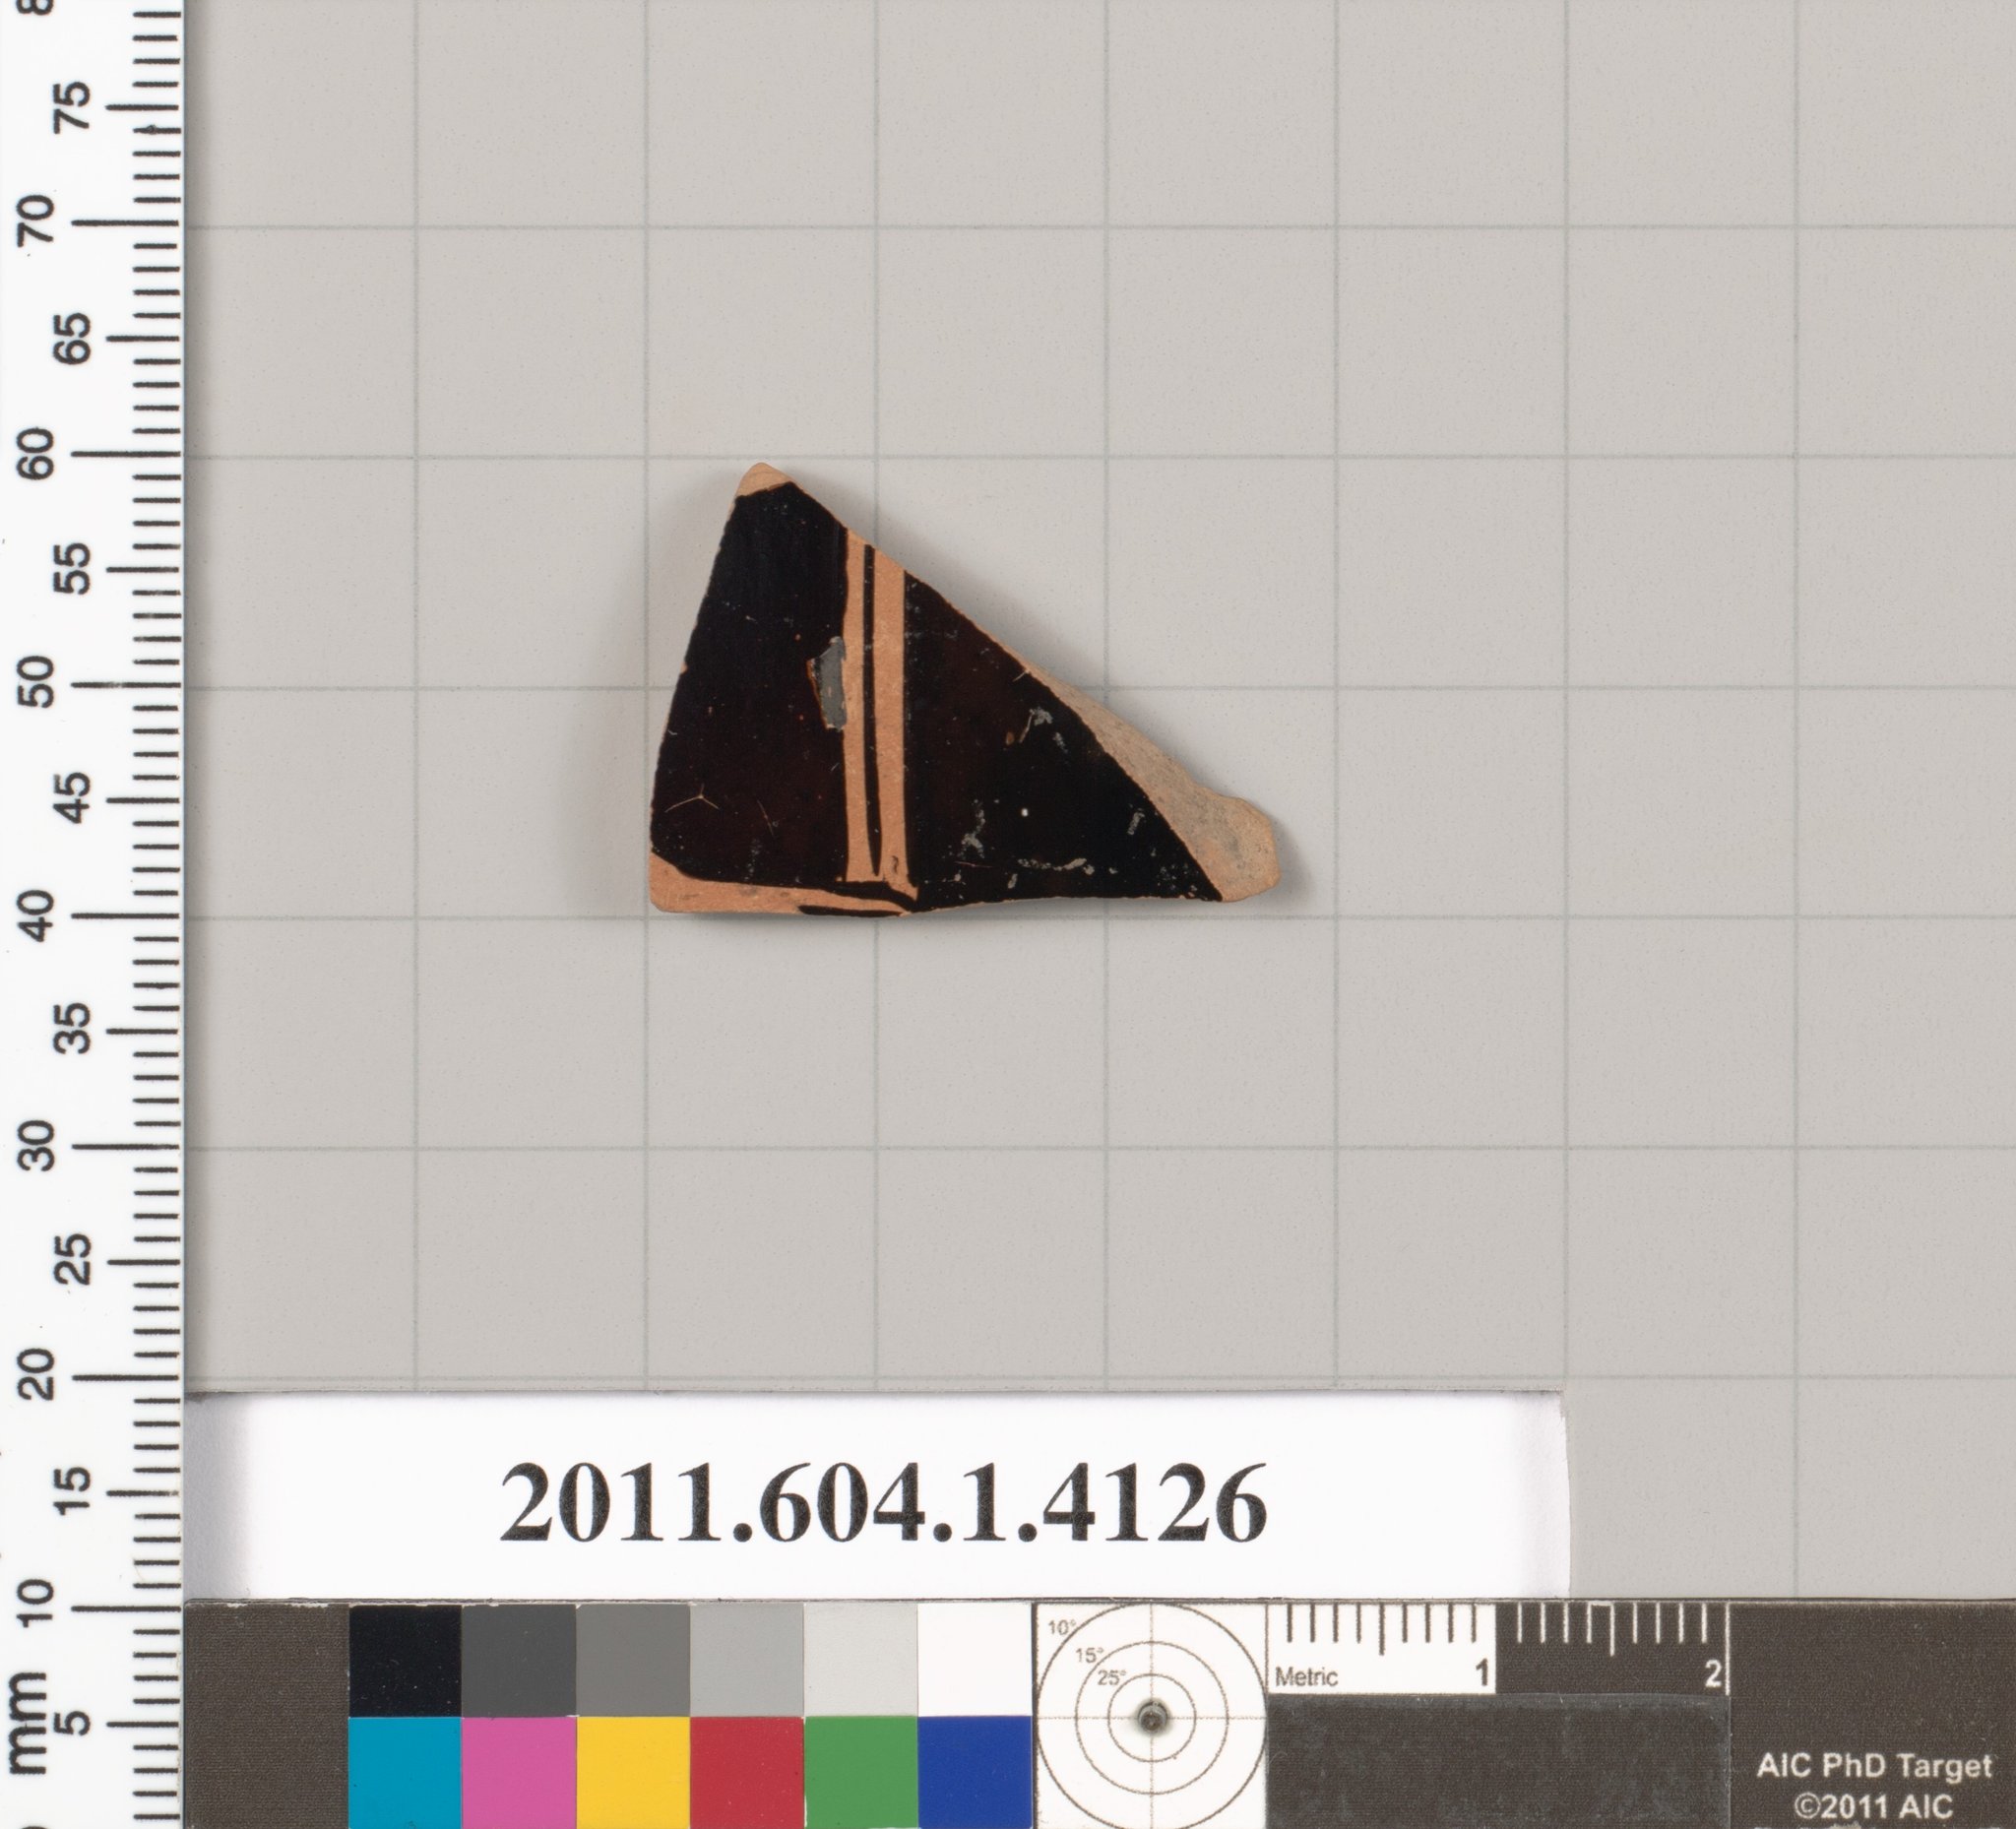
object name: kylix fragment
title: Terracotta fragment of a kylix (drinking cup)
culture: greek, attic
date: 490-470 BCE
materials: terracotta